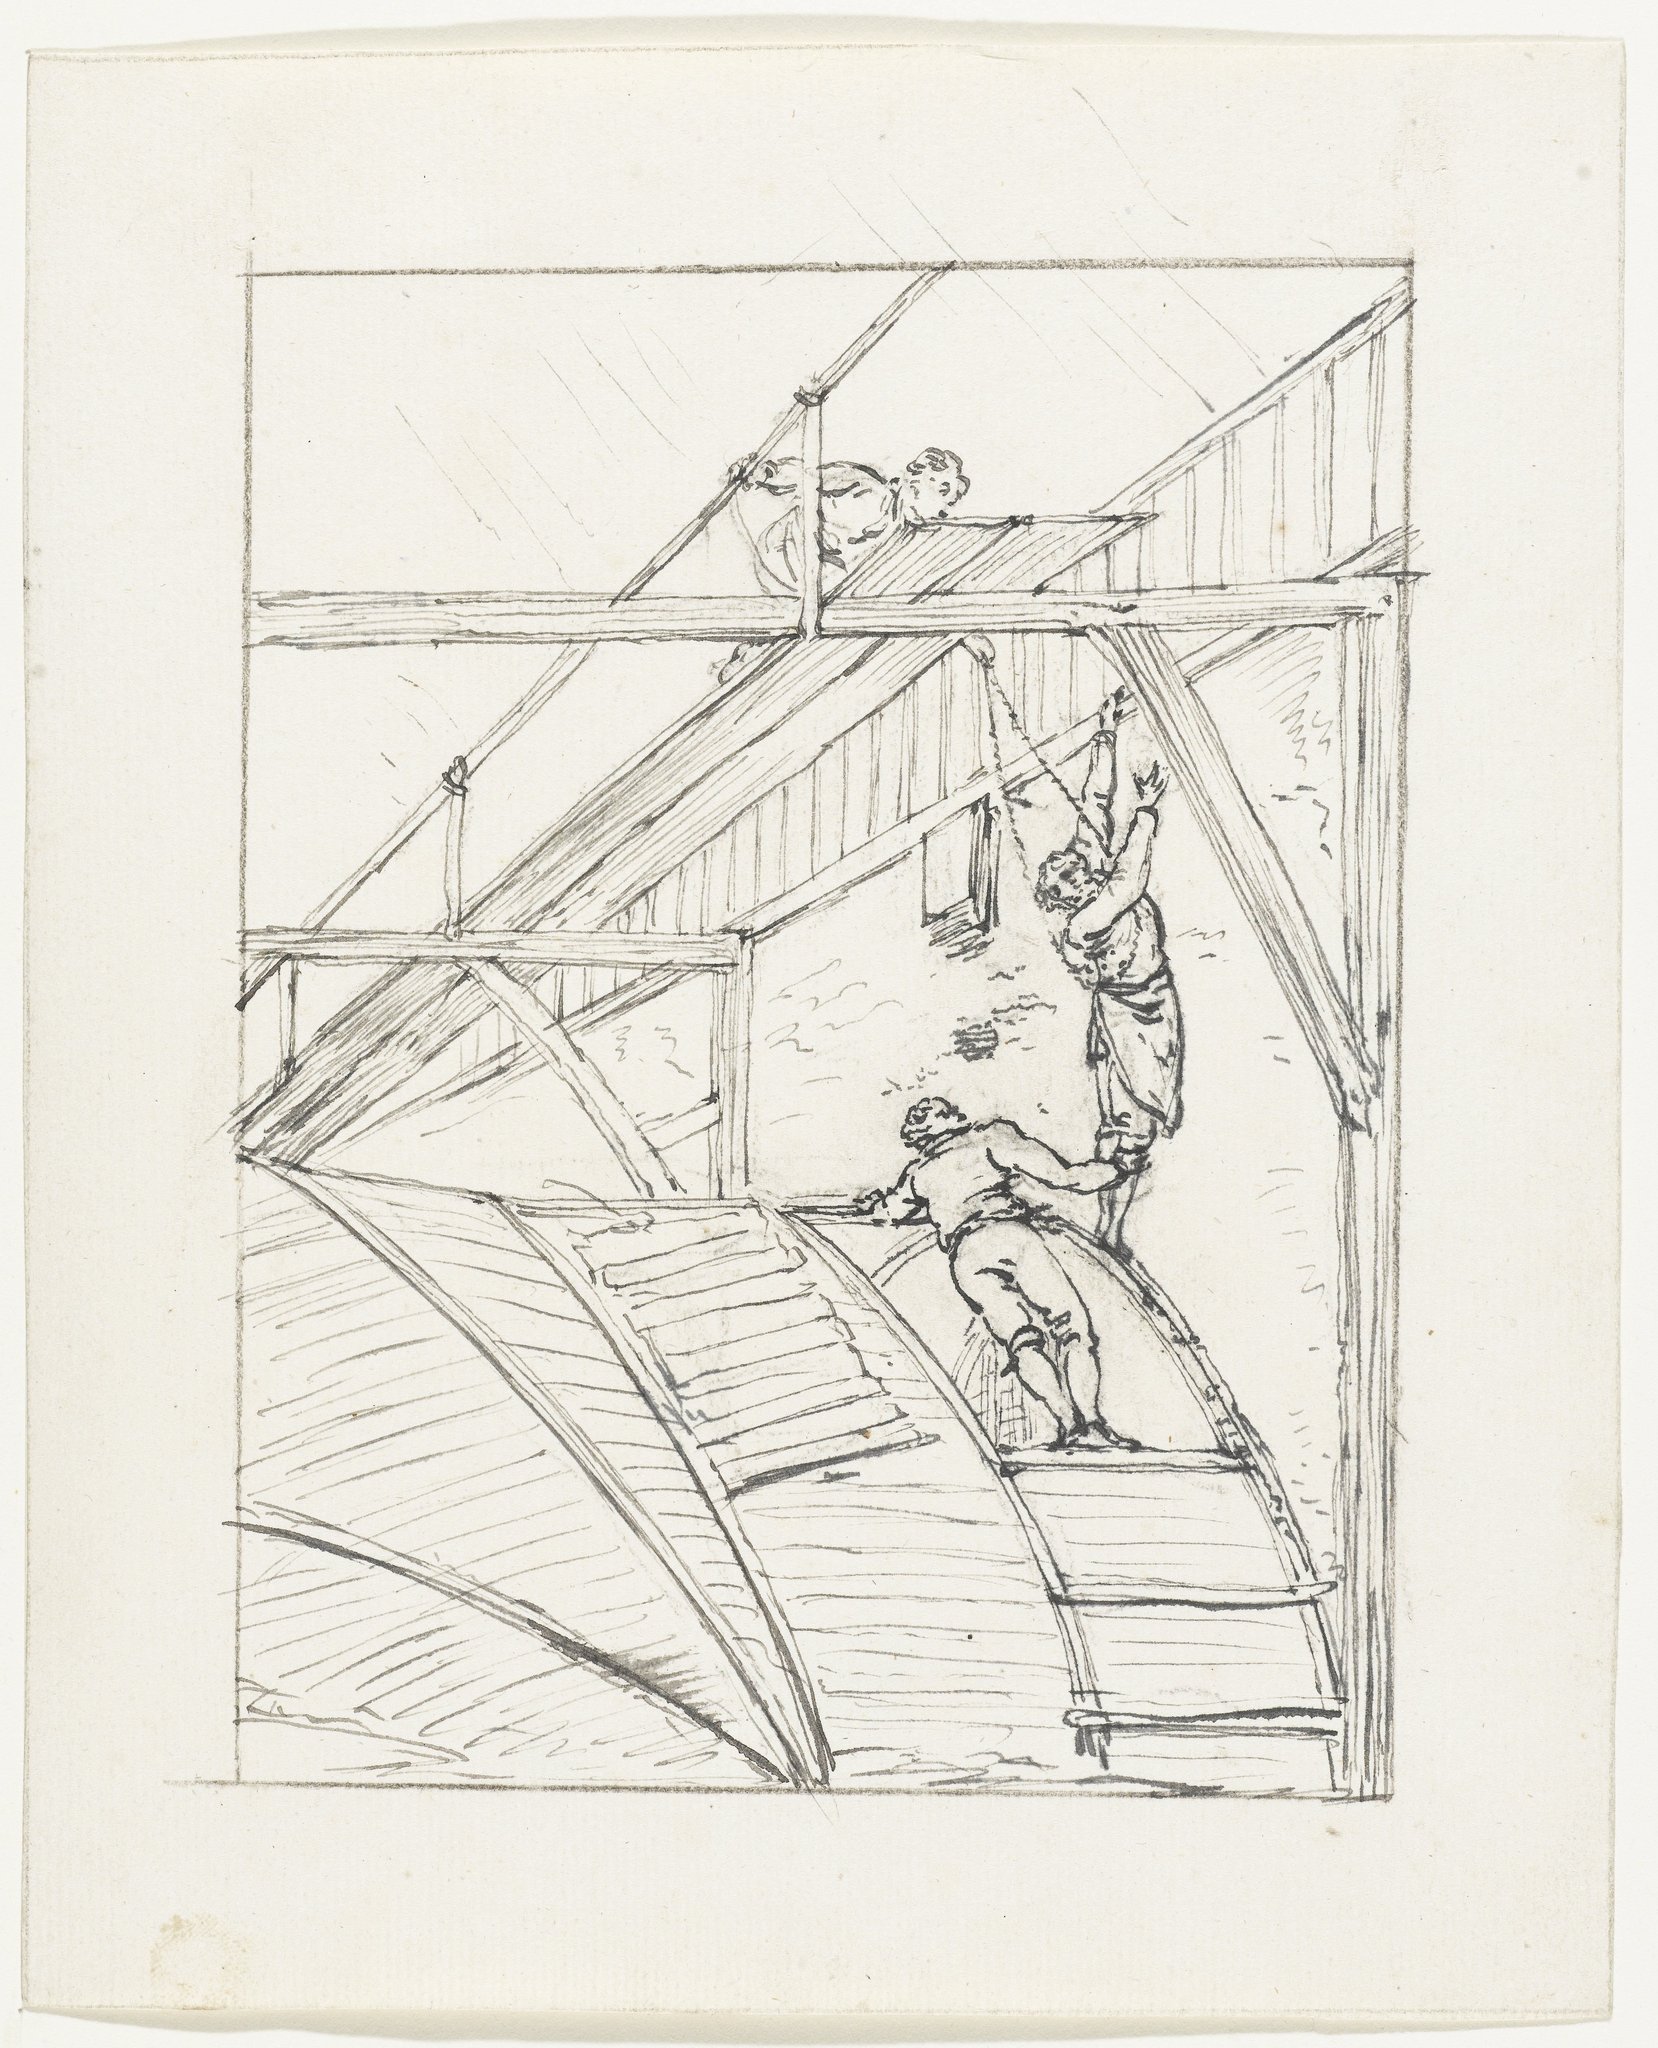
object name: drawing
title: Bouwwerkzaamheden in een vliering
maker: pieter bartholomeusz. barbiers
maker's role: draughtsman, print maker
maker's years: 1772-1837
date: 1782-1837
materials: graphite, ink, paper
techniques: pen